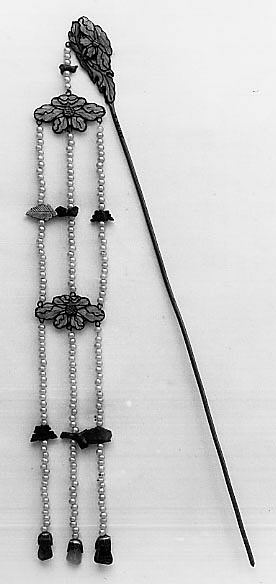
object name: hair pin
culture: chinese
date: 1701-1900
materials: gold, stone